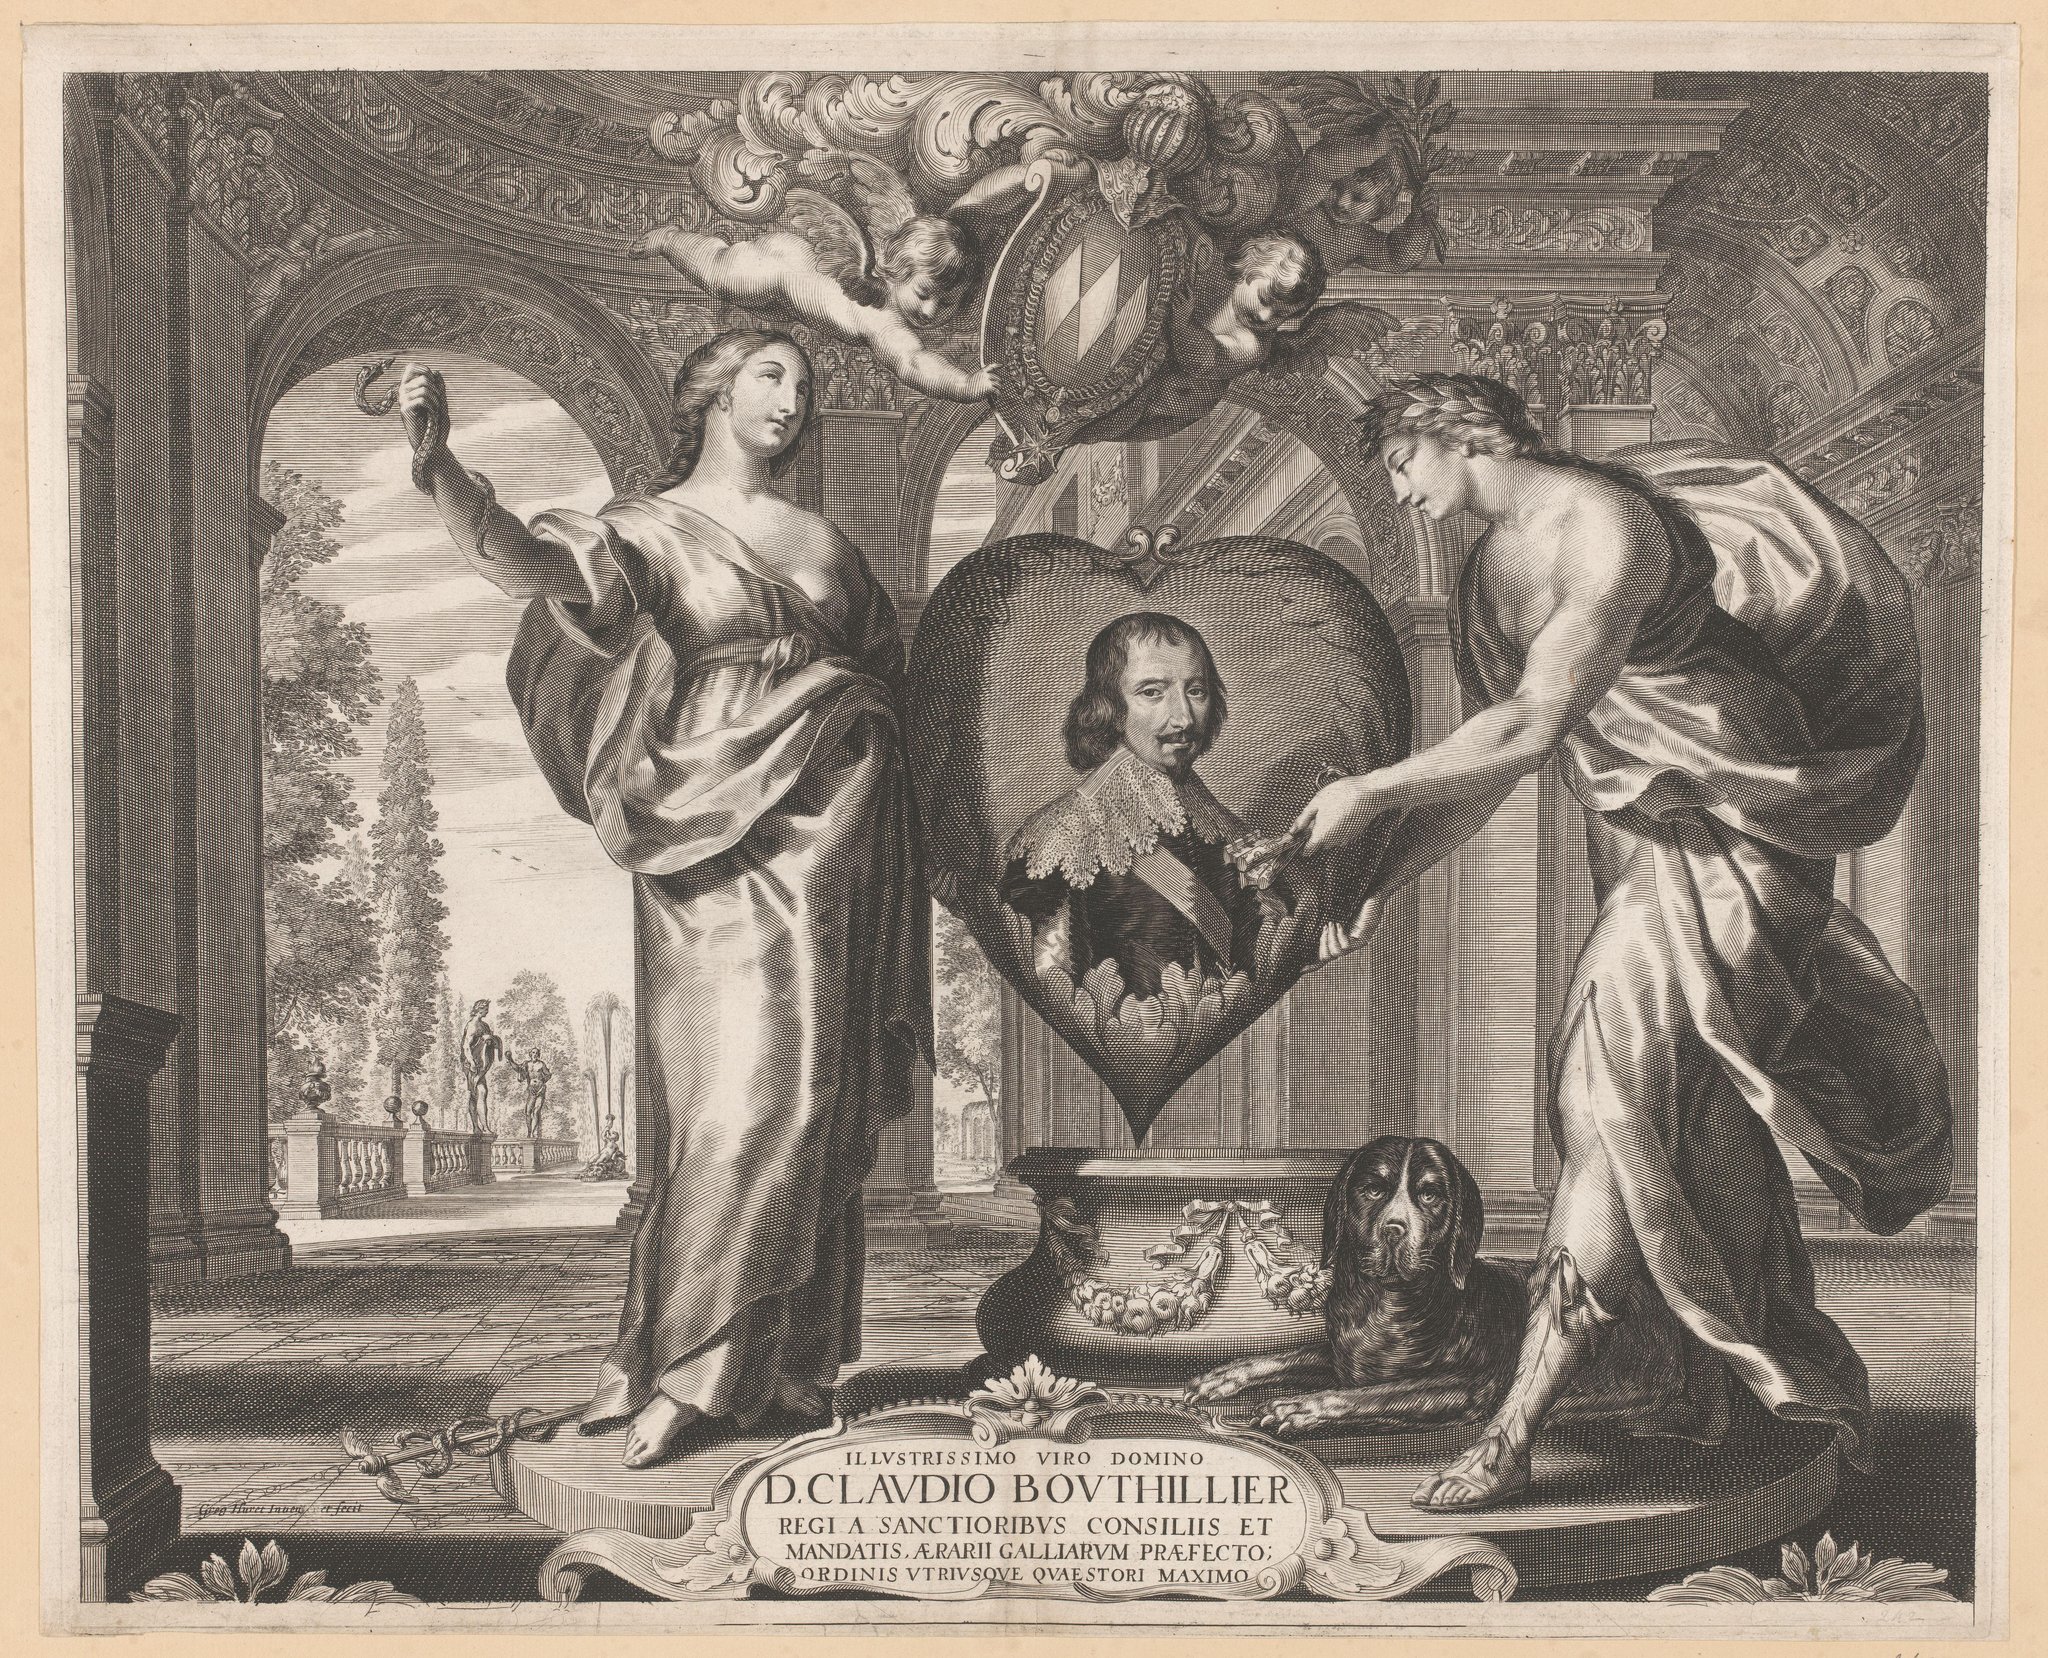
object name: print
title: Portret van Claude Bouthillier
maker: grégoire huret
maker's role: print maker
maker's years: 1606-1670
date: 1638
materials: paper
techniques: engraving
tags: paris, heart symbolism, fidelity; 'fedeltà' (ripa), wisdom; 'sapienza', 'sapienza humana', 'sapienza vera' (ripa), historical persons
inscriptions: collector's mark: Lugt 240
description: Dit betreft de bovenste helft van een gravure voor de thesis van Antoine de Bretagne (zie British Museum, inv.nr. 1928,0313.356).